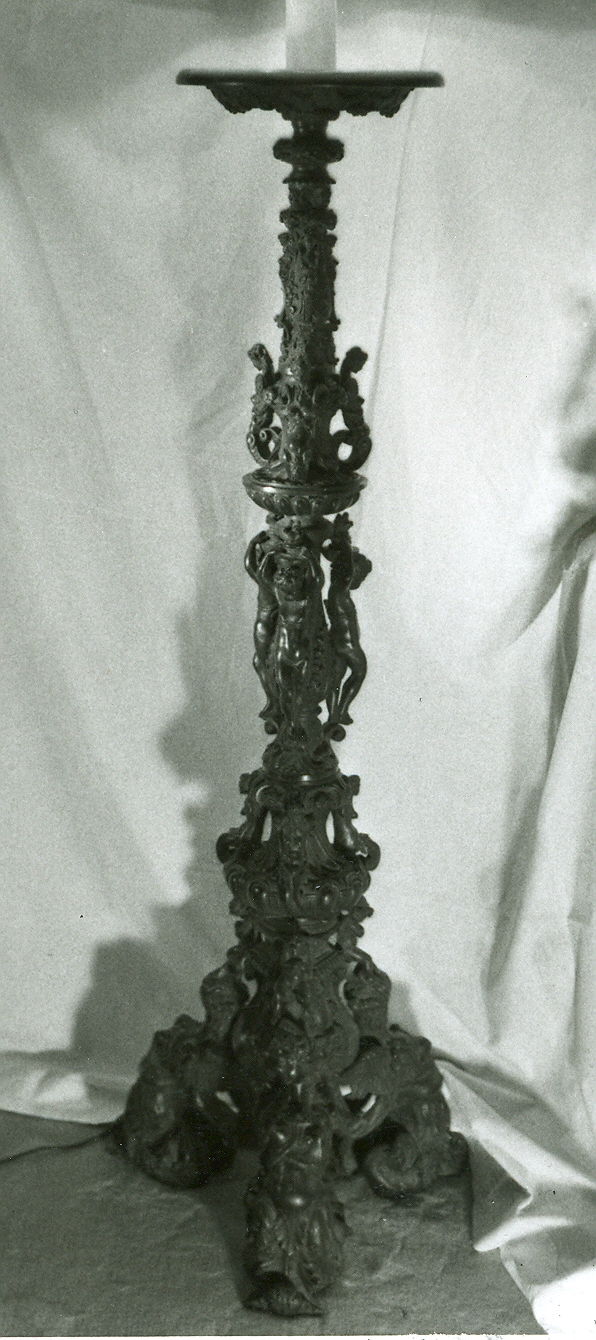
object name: candelabrum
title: Candelabra supported by three female demi-figures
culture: italian, veneto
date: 1501-1600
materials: copper alloy, patina